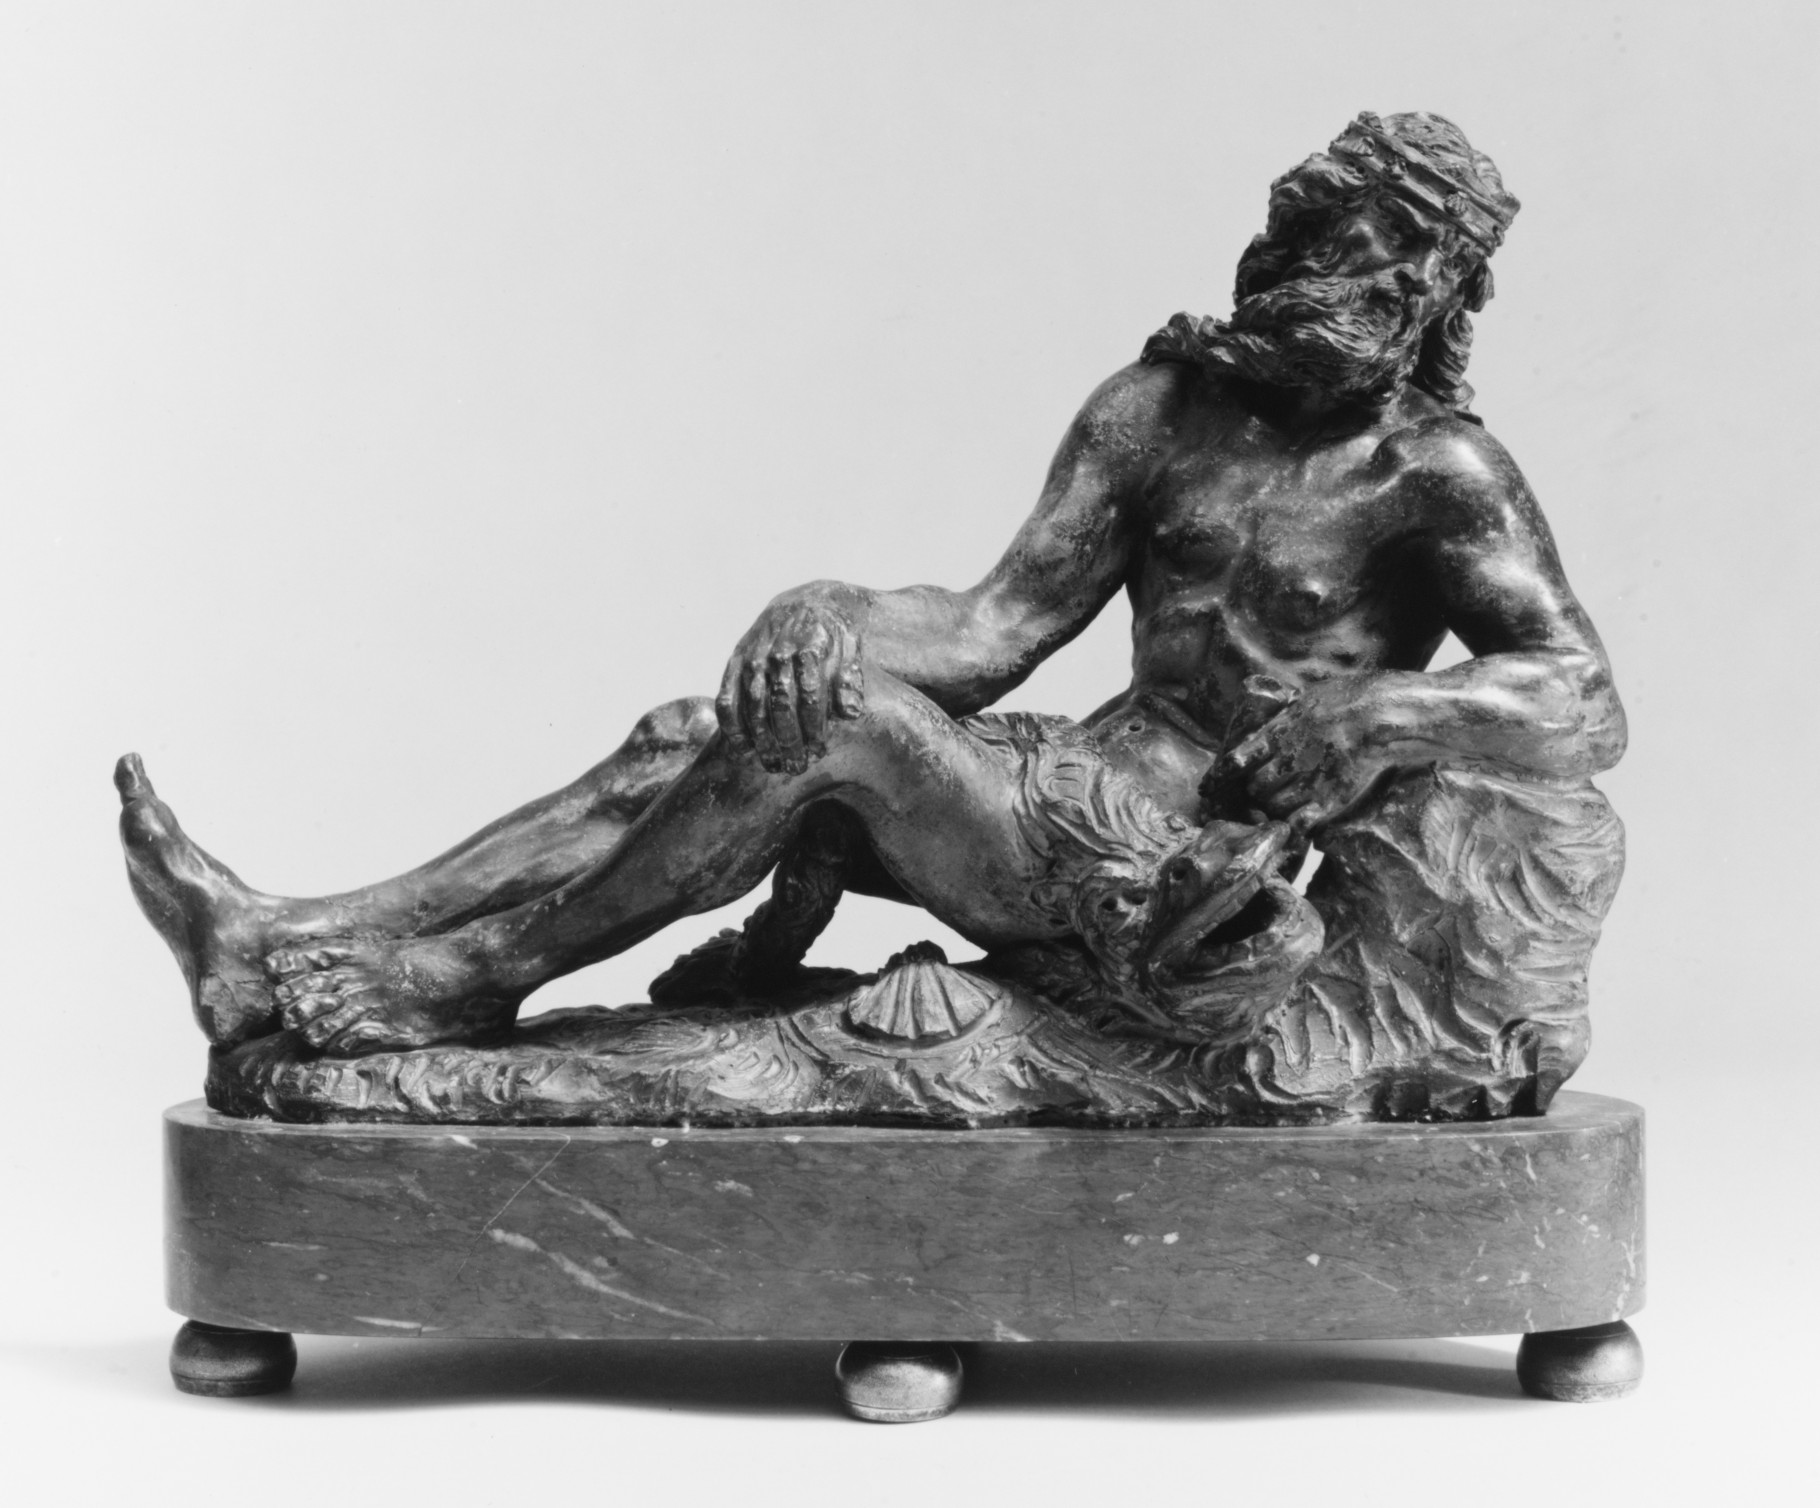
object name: statuette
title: Neptune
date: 1700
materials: gilt bronze, marble, terracotta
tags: neptune